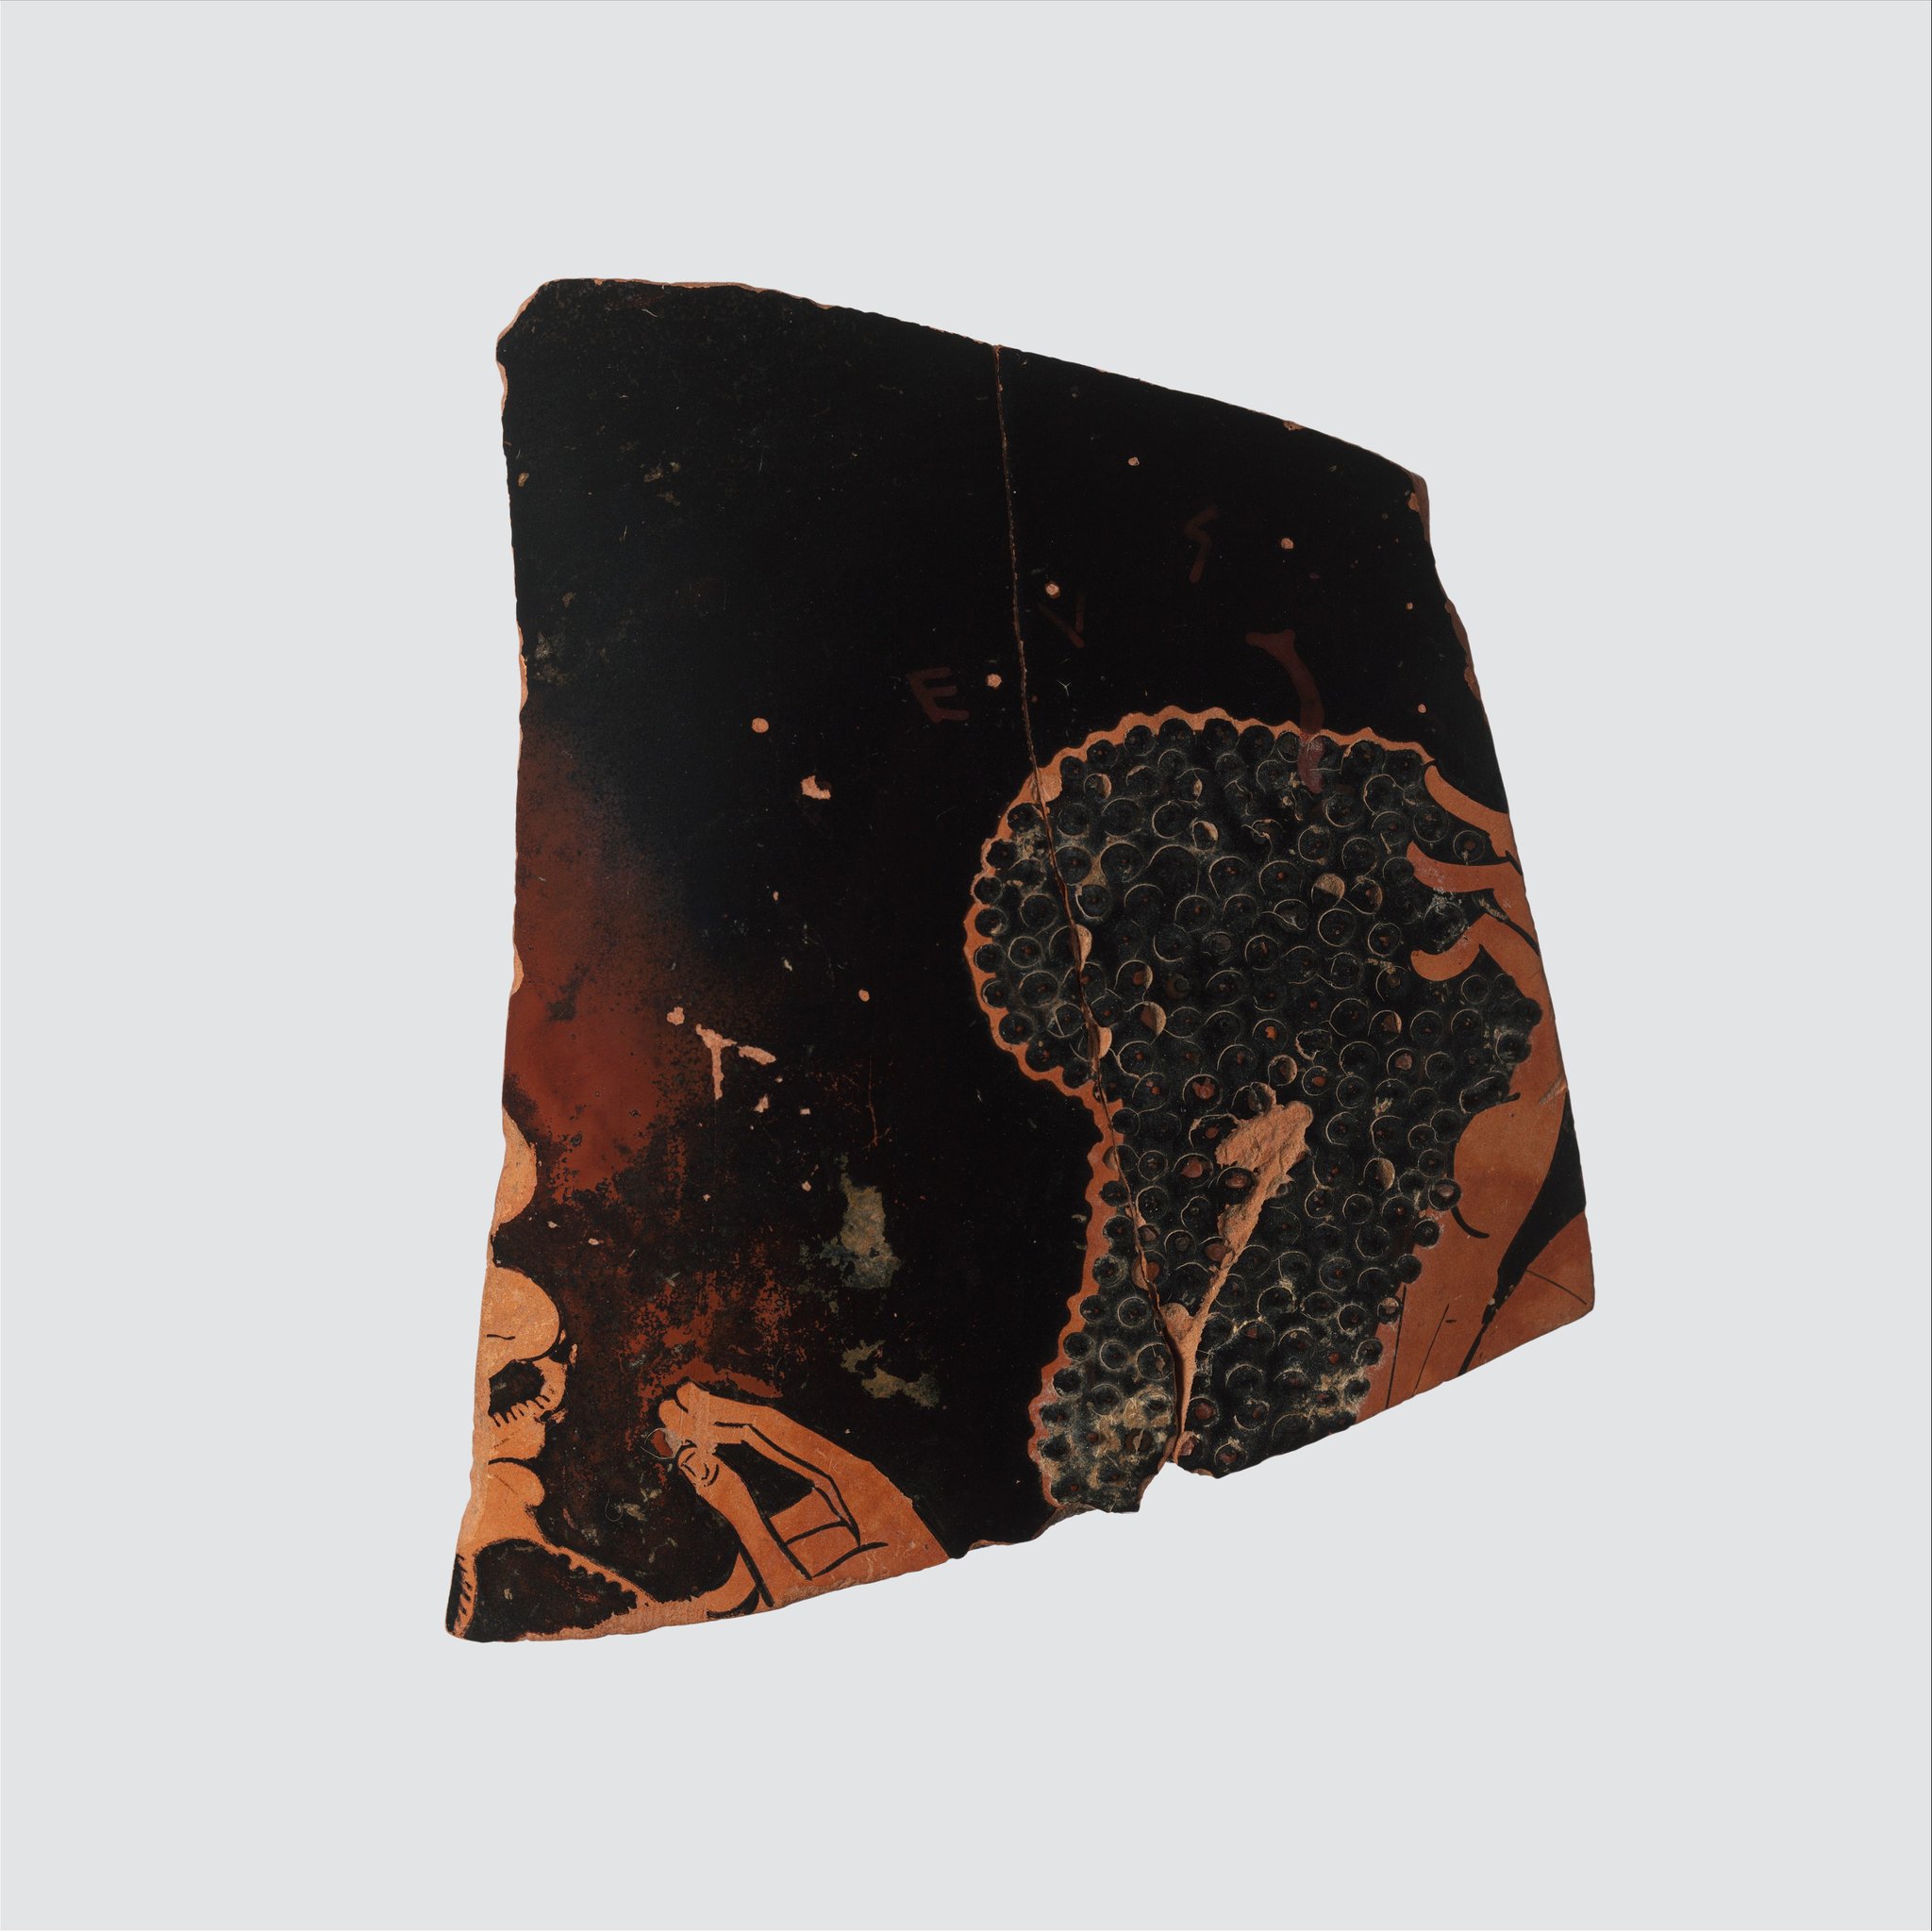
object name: neck amphora, fragmentary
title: Fragment of a terracotta neck-amphora (jar)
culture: greek, attic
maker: euphronios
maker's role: artist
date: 515 BCE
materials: terracotta